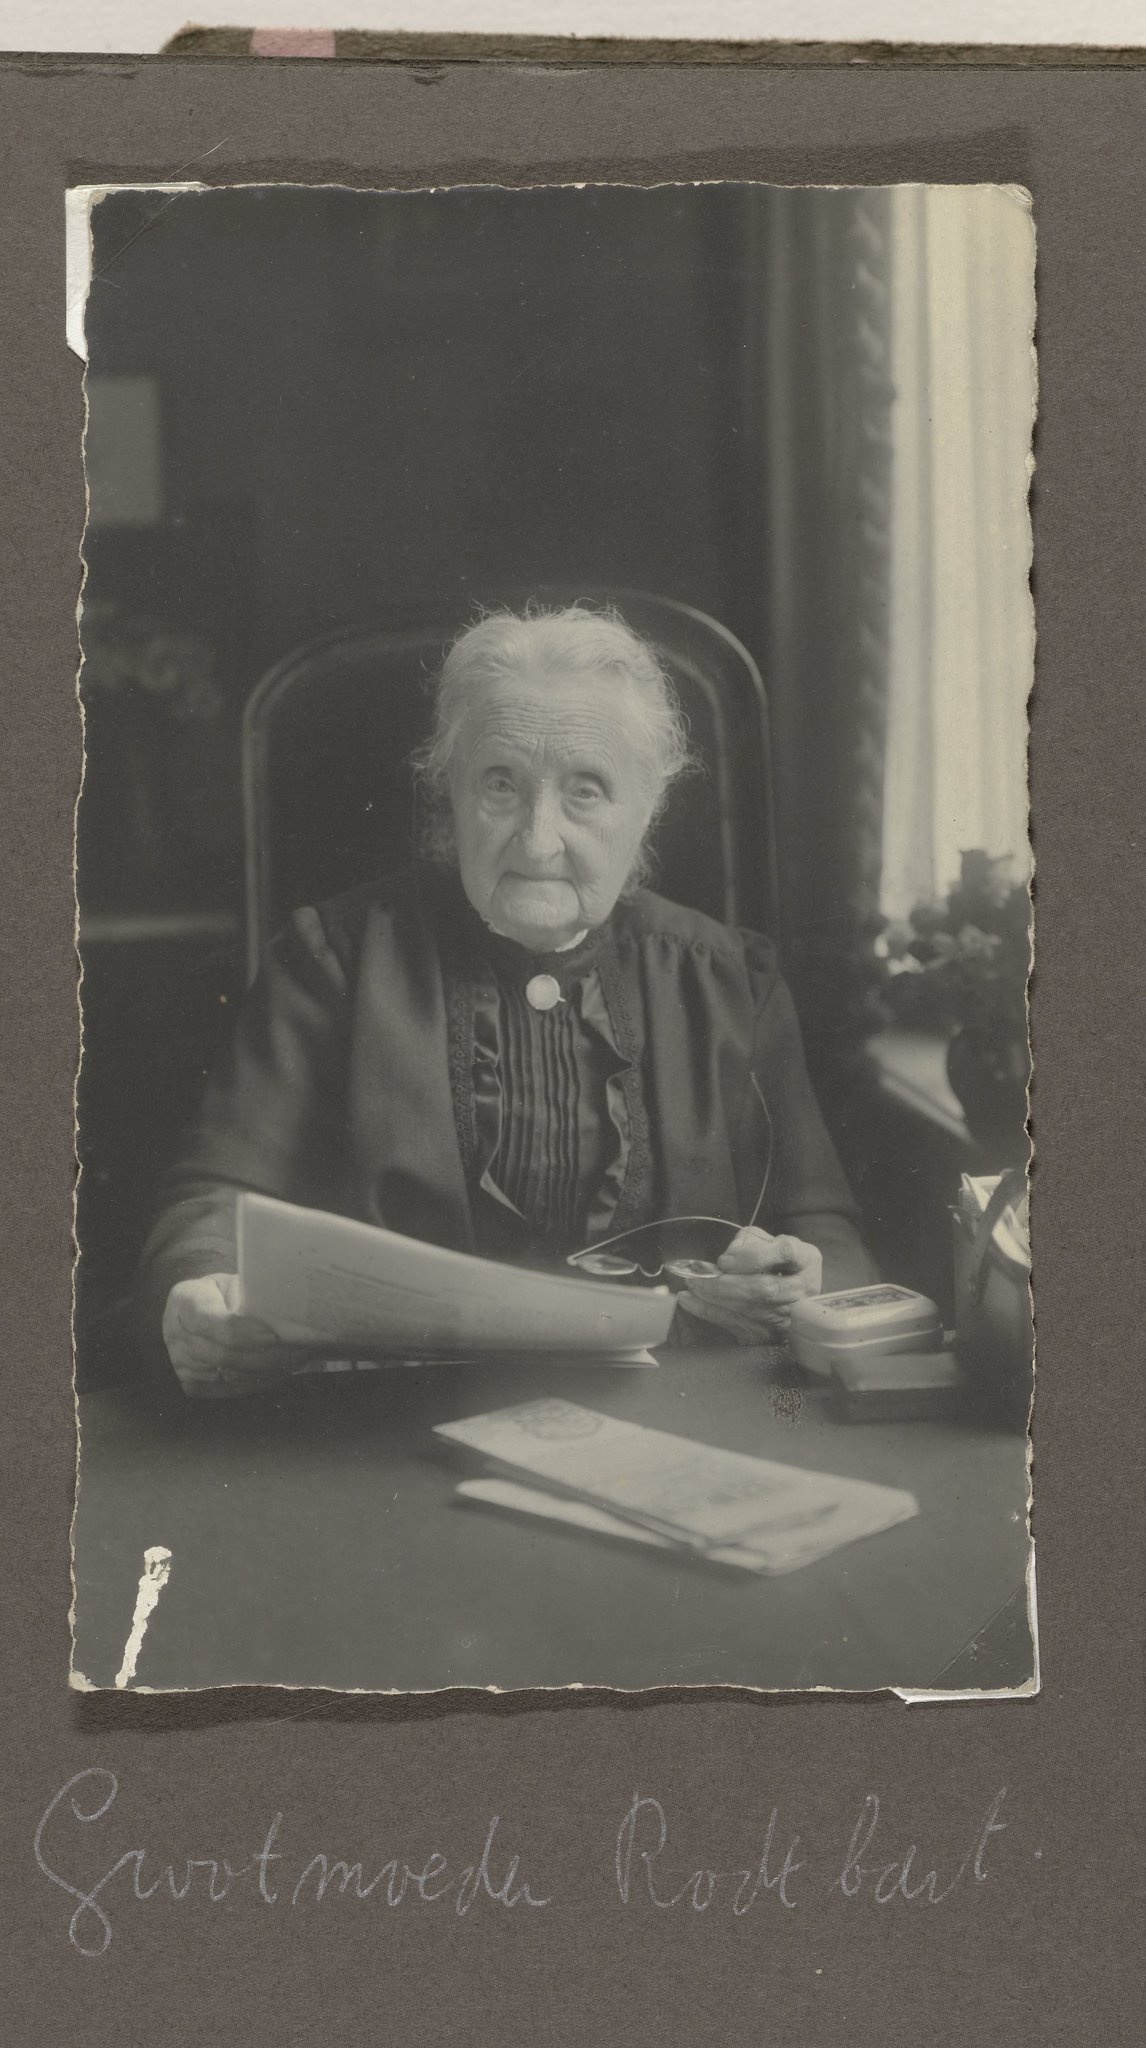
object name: photograph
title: Portret van een vrouw, aangeduid als grootmoeder Rodtbart, lezend in de krant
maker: cornelis johannes lodewicus vermeulen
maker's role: fotograaf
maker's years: 1861-1936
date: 1920-1930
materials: paper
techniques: gelatin silver print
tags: reading, historical persons - bb - woman, newspaper, news-sheet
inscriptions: inscription: ‘grootmoeder Rodtbart’